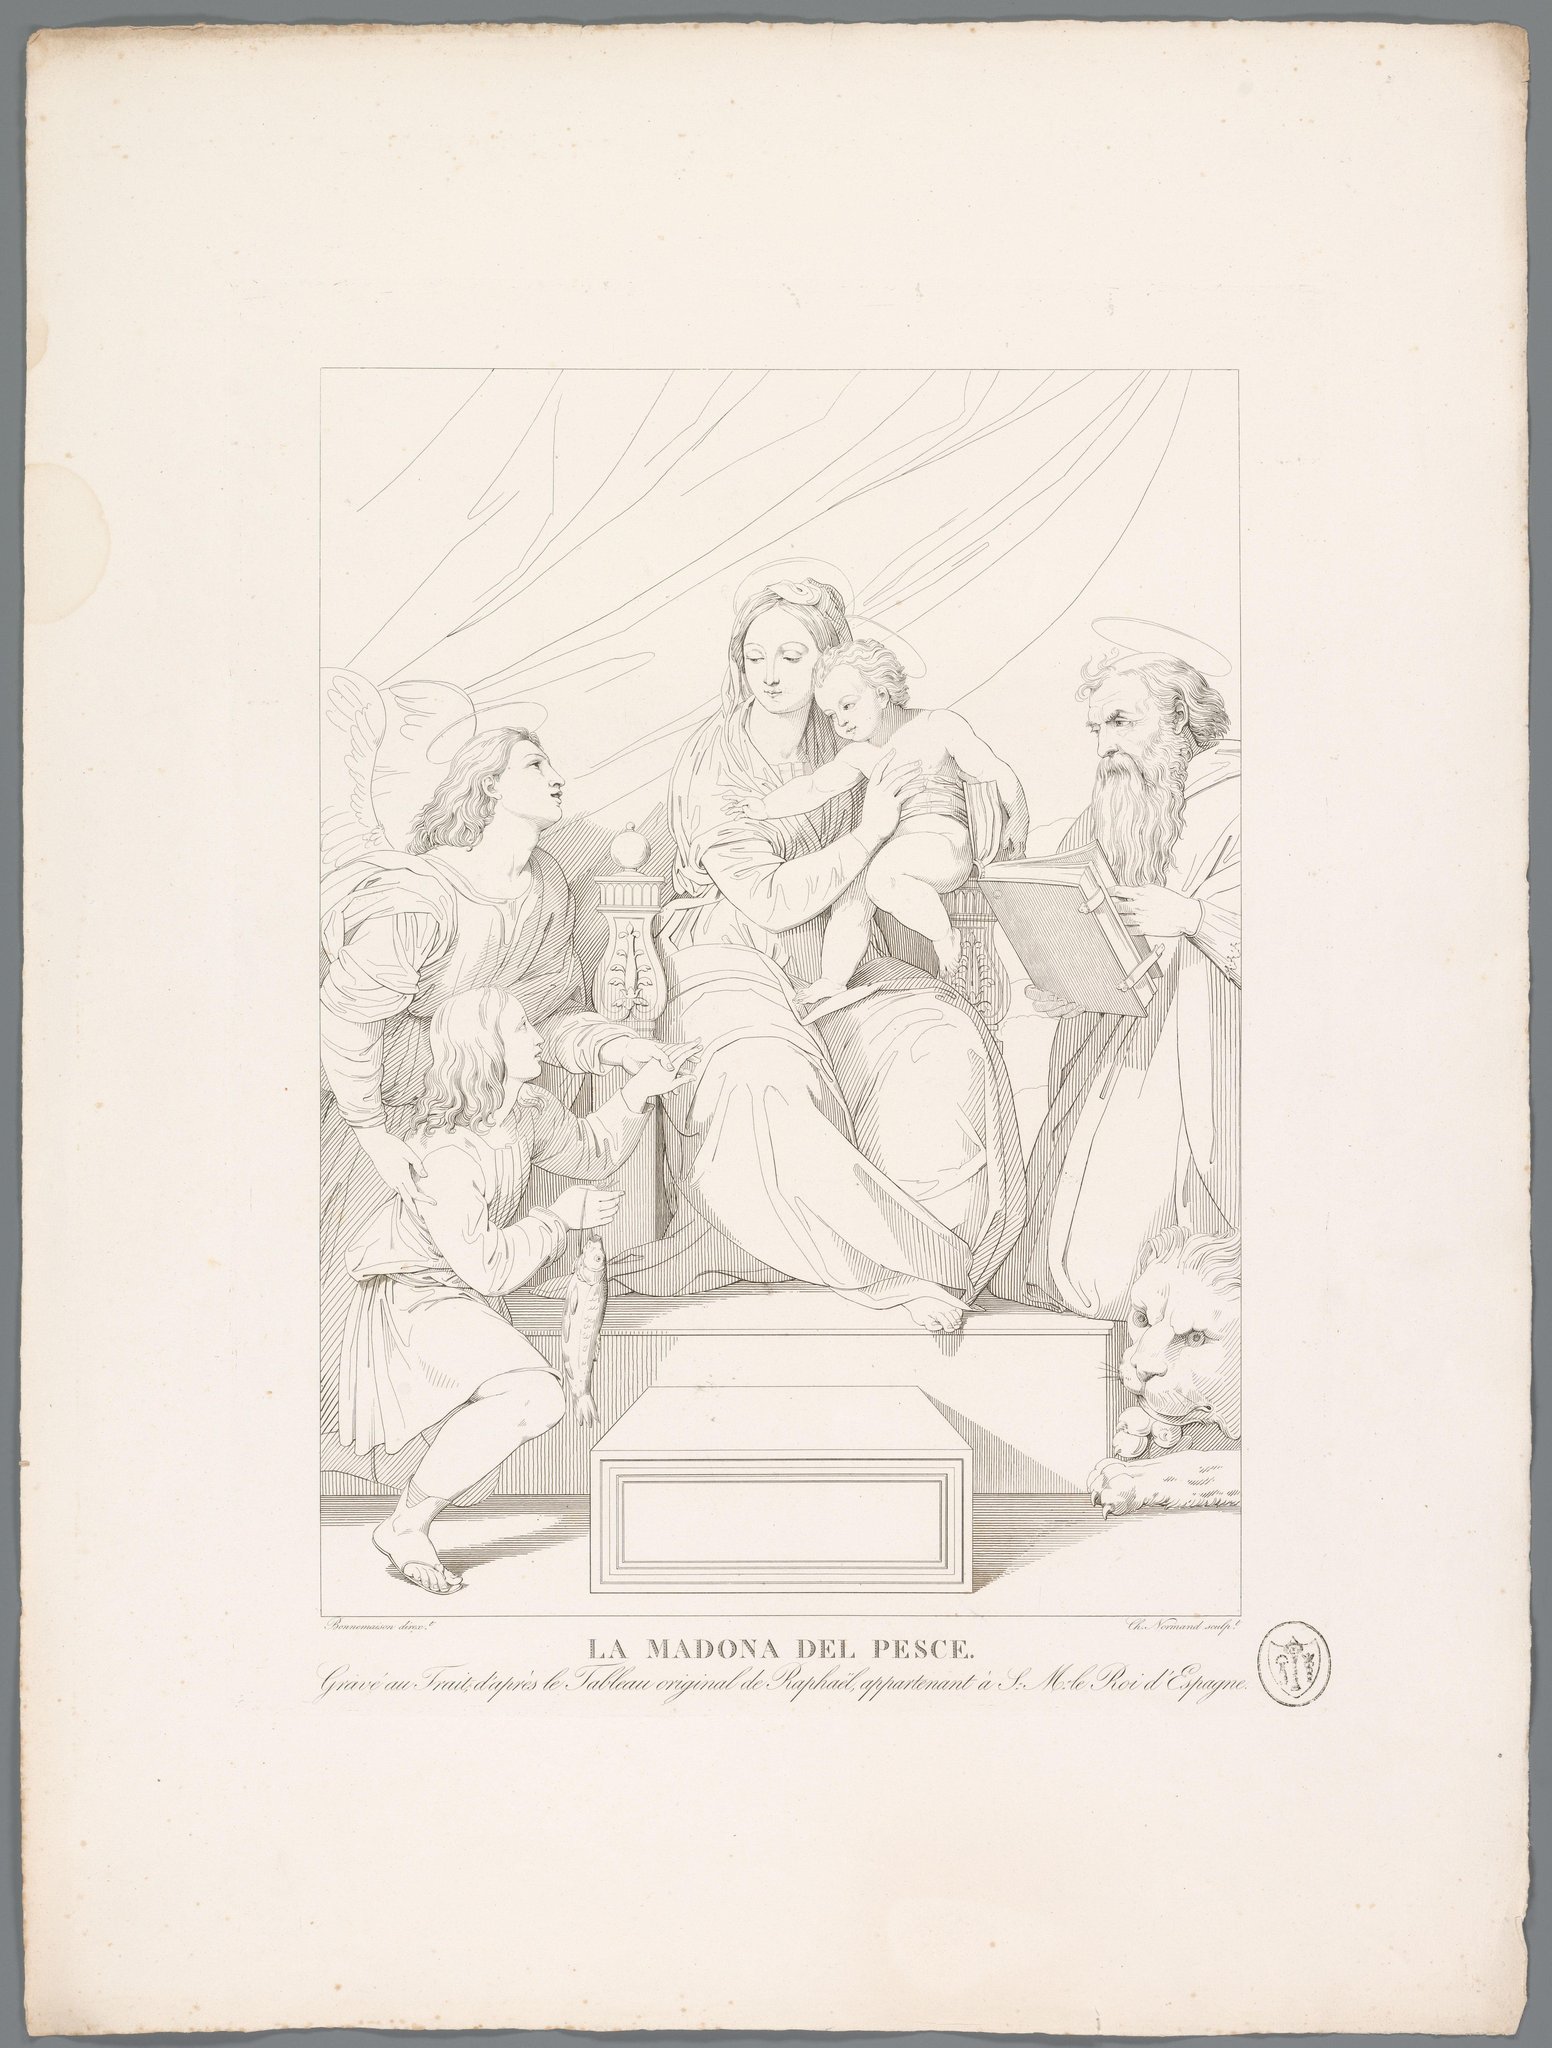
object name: print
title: Prenten naar vijf schilderijen door Rafael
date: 1818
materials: paper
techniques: etching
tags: madonna: i.e. mary with the christ-child, story of tobias: tobias and sarah (tobit 7-9), the monk and hermit jerome (hieronymus); possible attributes: book, cardinal's hat, crucifix, hour-glass, lion, skull, stone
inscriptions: collector's mark: Lugt 4583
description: Maakt deel uit van een omslag met 8 prenten en 5 tekstbladen naar details van schilderijen door Rafaël. De serie kwam tot stand onder toezicht van Féréol Bonnemaison en werd voorzien van tekst door Toussaint-Bernard Émeric-David. Het geheel werd uitgegeven door Féréol Bonnemaison en Mesdemoiselles Érard te Parijs en gedrukt door Pierre I Didot in 1818. Het schilderij bevindt zich in de collectie van het Museo del Prado te Madrid, inv.nr. P000297 en staat ook wel bekend als de Madonna del Pesce.